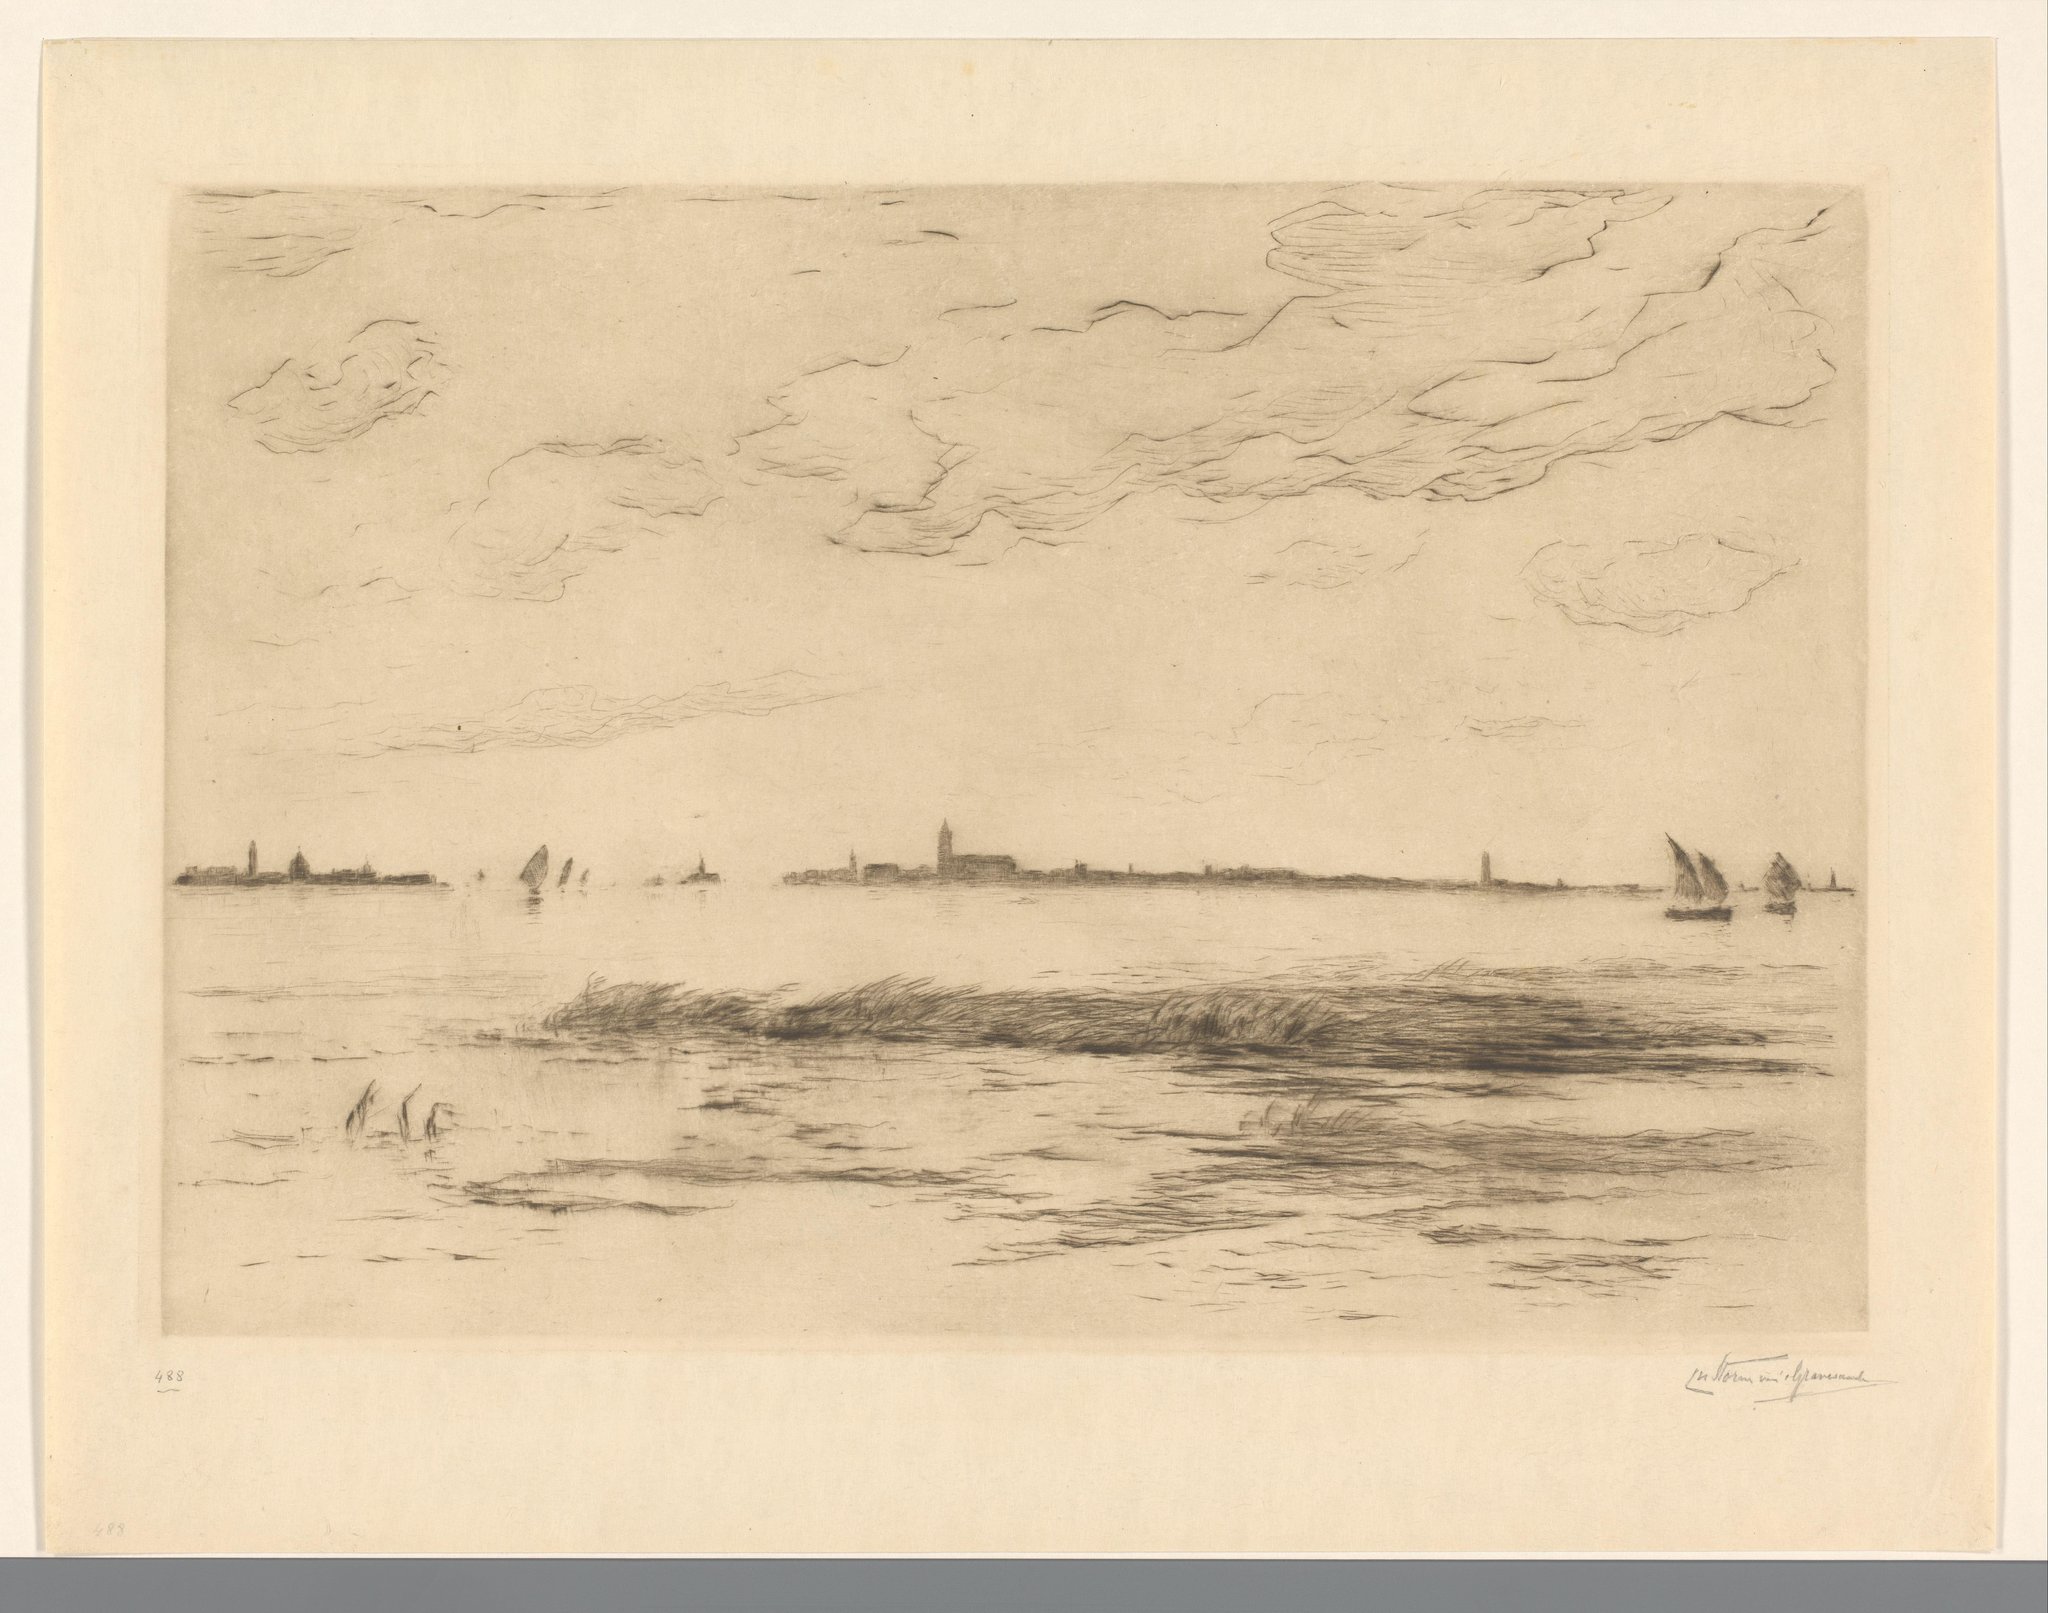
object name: print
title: Zeilboten op het water, in de verte een stad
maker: carel nicolaas storm van s-gravesande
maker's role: draughtsman, print maker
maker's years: 1841-1924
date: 1851-1924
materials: paper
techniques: drypoint, intaglio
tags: traffic on the water, prospect of city, town panorama, silhouette of city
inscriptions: collector's mark: Lugt 2228